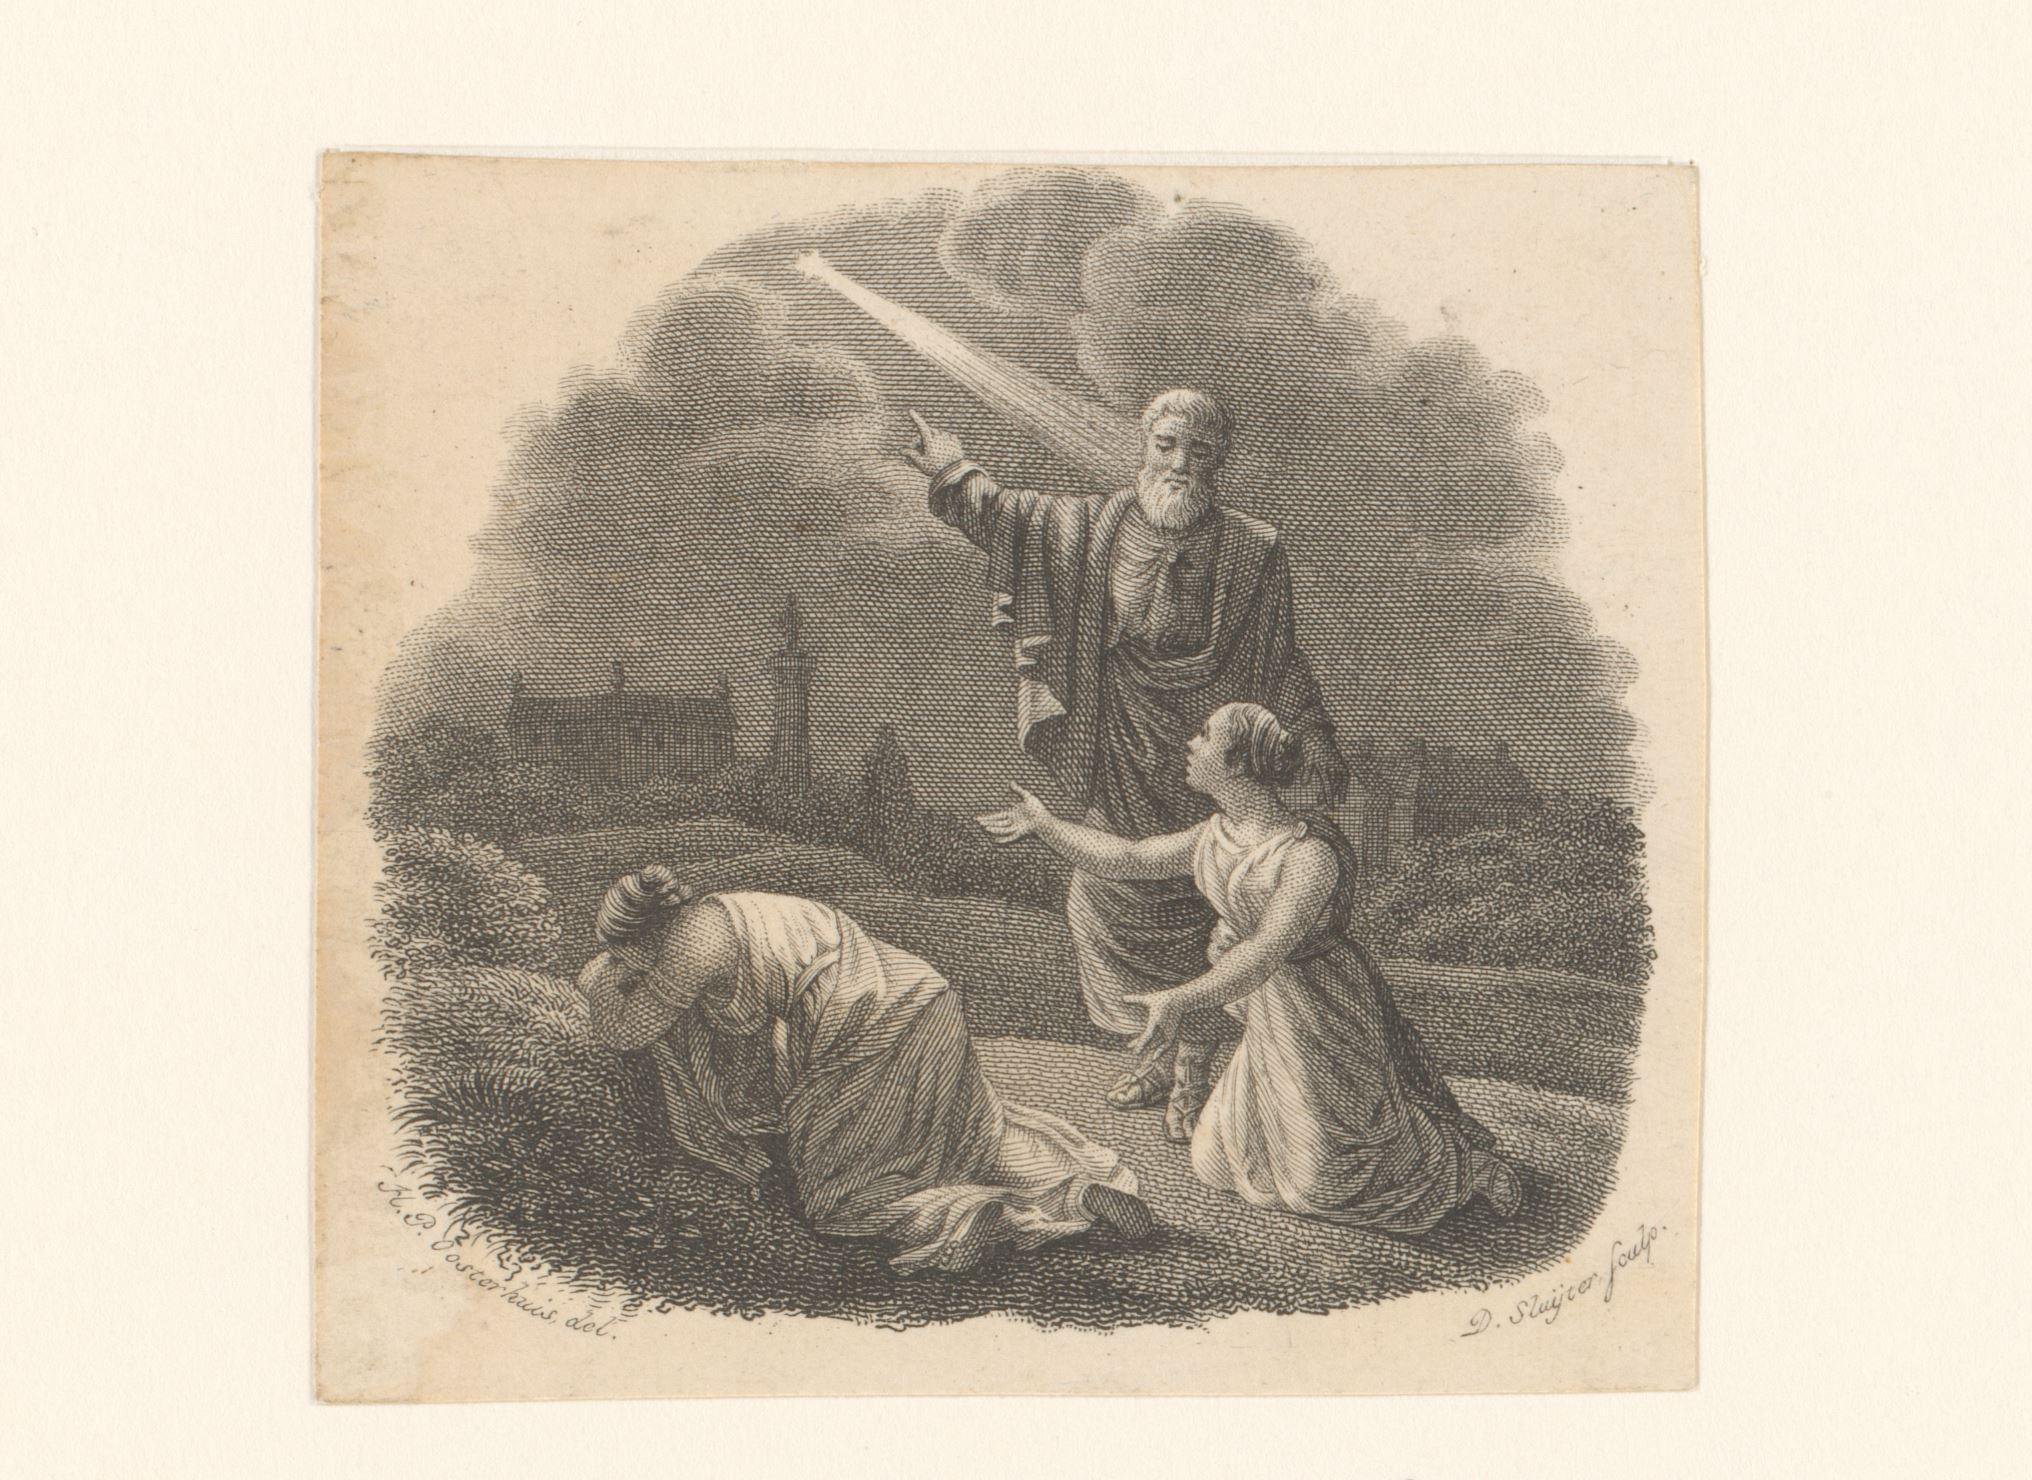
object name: print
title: Man wijst twee vrouwen op een ster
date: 1800-1852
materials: paper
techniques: engraving, etching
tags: weeping, index finger forwards, pointing, indicating, stars and constellations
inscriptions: collector's mark: Lugt 2228